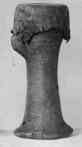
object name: drum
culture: sogo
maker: soga people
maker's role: maker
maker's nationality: uganda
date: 1801-1900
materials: skin, wood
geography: uganda